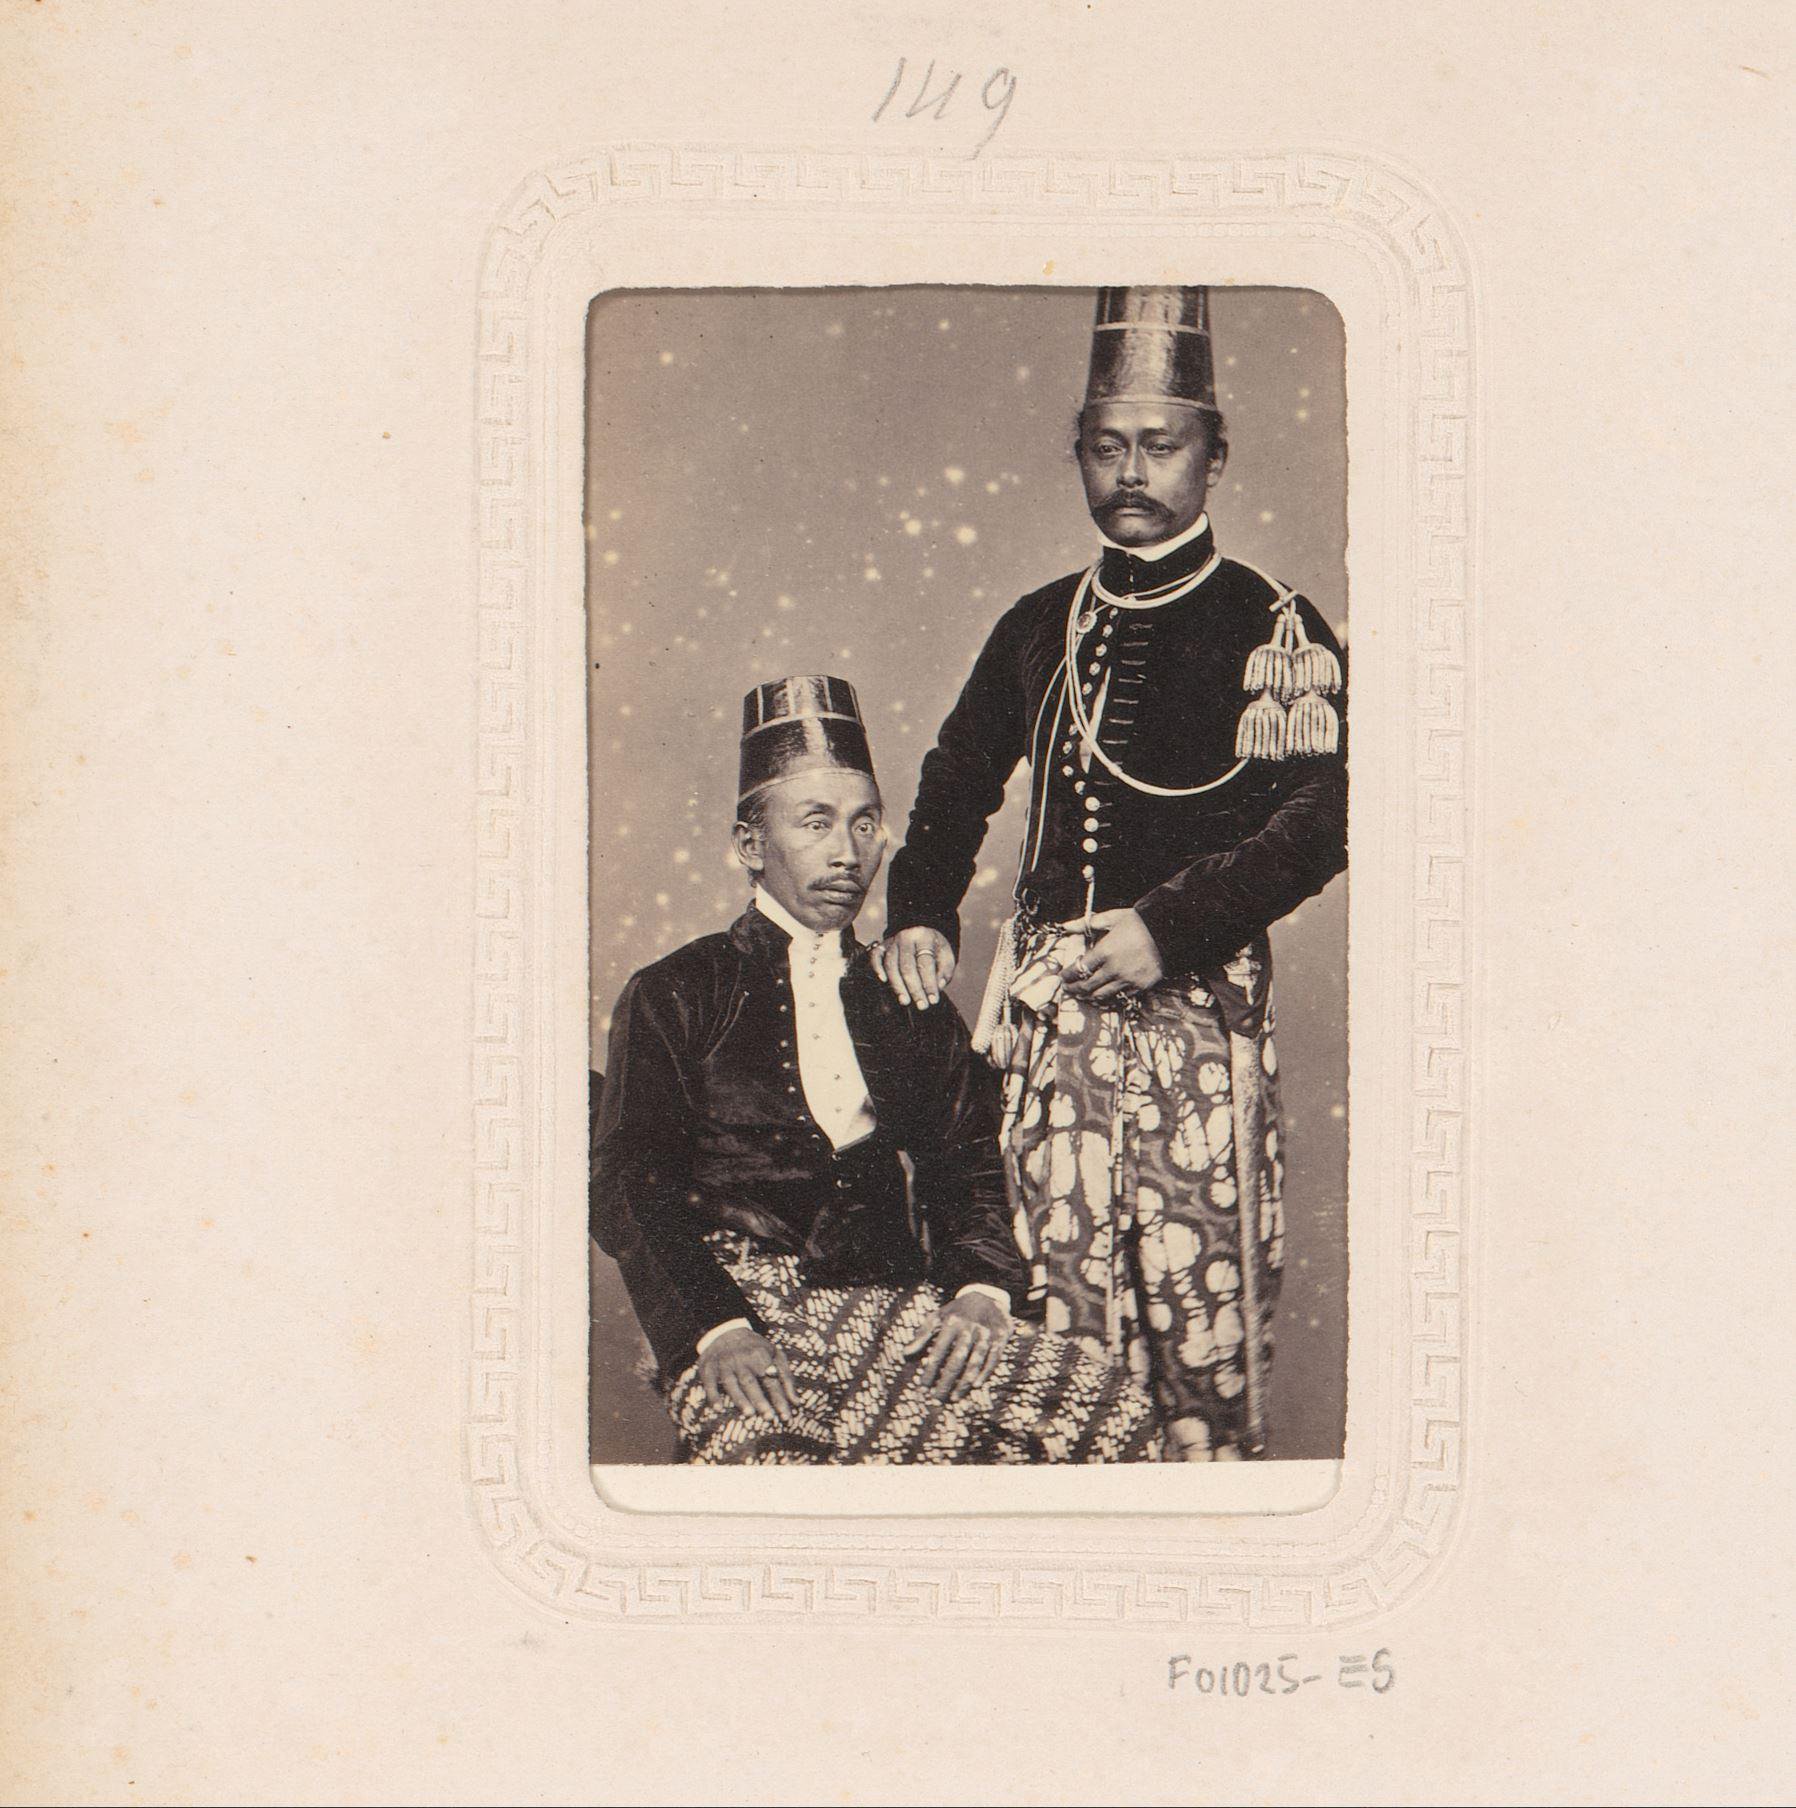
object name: album leaf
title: Portret van twee Indonesische mannen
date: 1857-1880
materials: cardboard, photographic support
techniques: albumen print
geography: java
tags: historical persons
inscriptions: inscription: ‘Woodbury & Page/ Photographers/ Java’, number: ‘149’